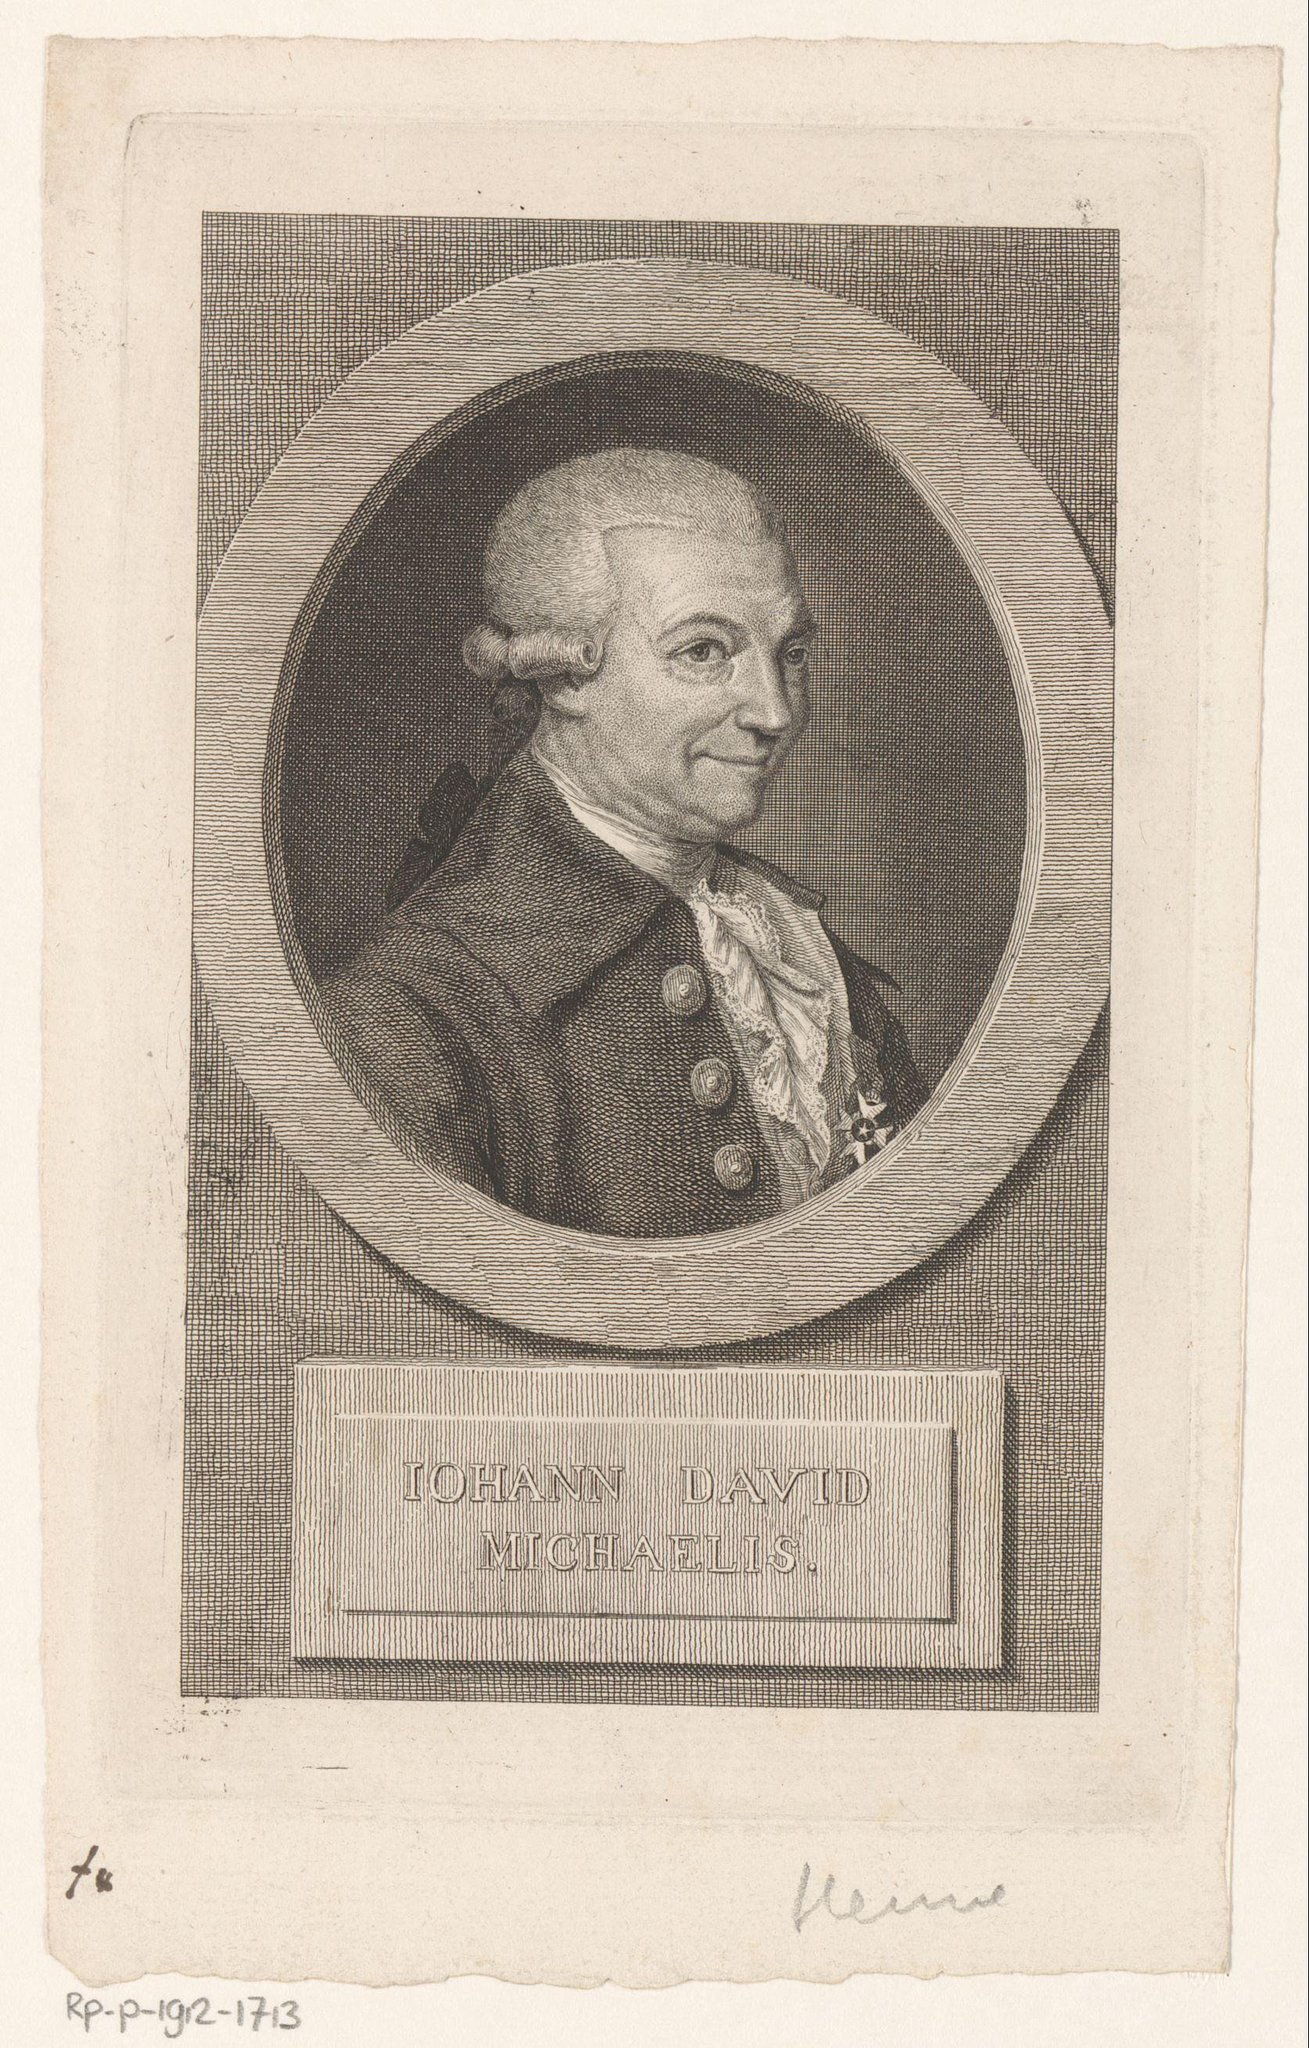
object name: print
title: Portret van Johann David Michaelis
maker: eberhard siegfried henne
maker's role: print maker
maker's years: 1759-1828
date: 1788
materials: paper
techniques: engraving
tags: theologian, scholar, philosopher, historical persons, medals and other marks of military honour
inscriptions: collector's mark: Lugt 2228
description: Prent gebruikt voor: Allgemeine deutsche Bibliothek. Berlijn en Stettin: Friedrich Nicolai, 1788, dl. 84.